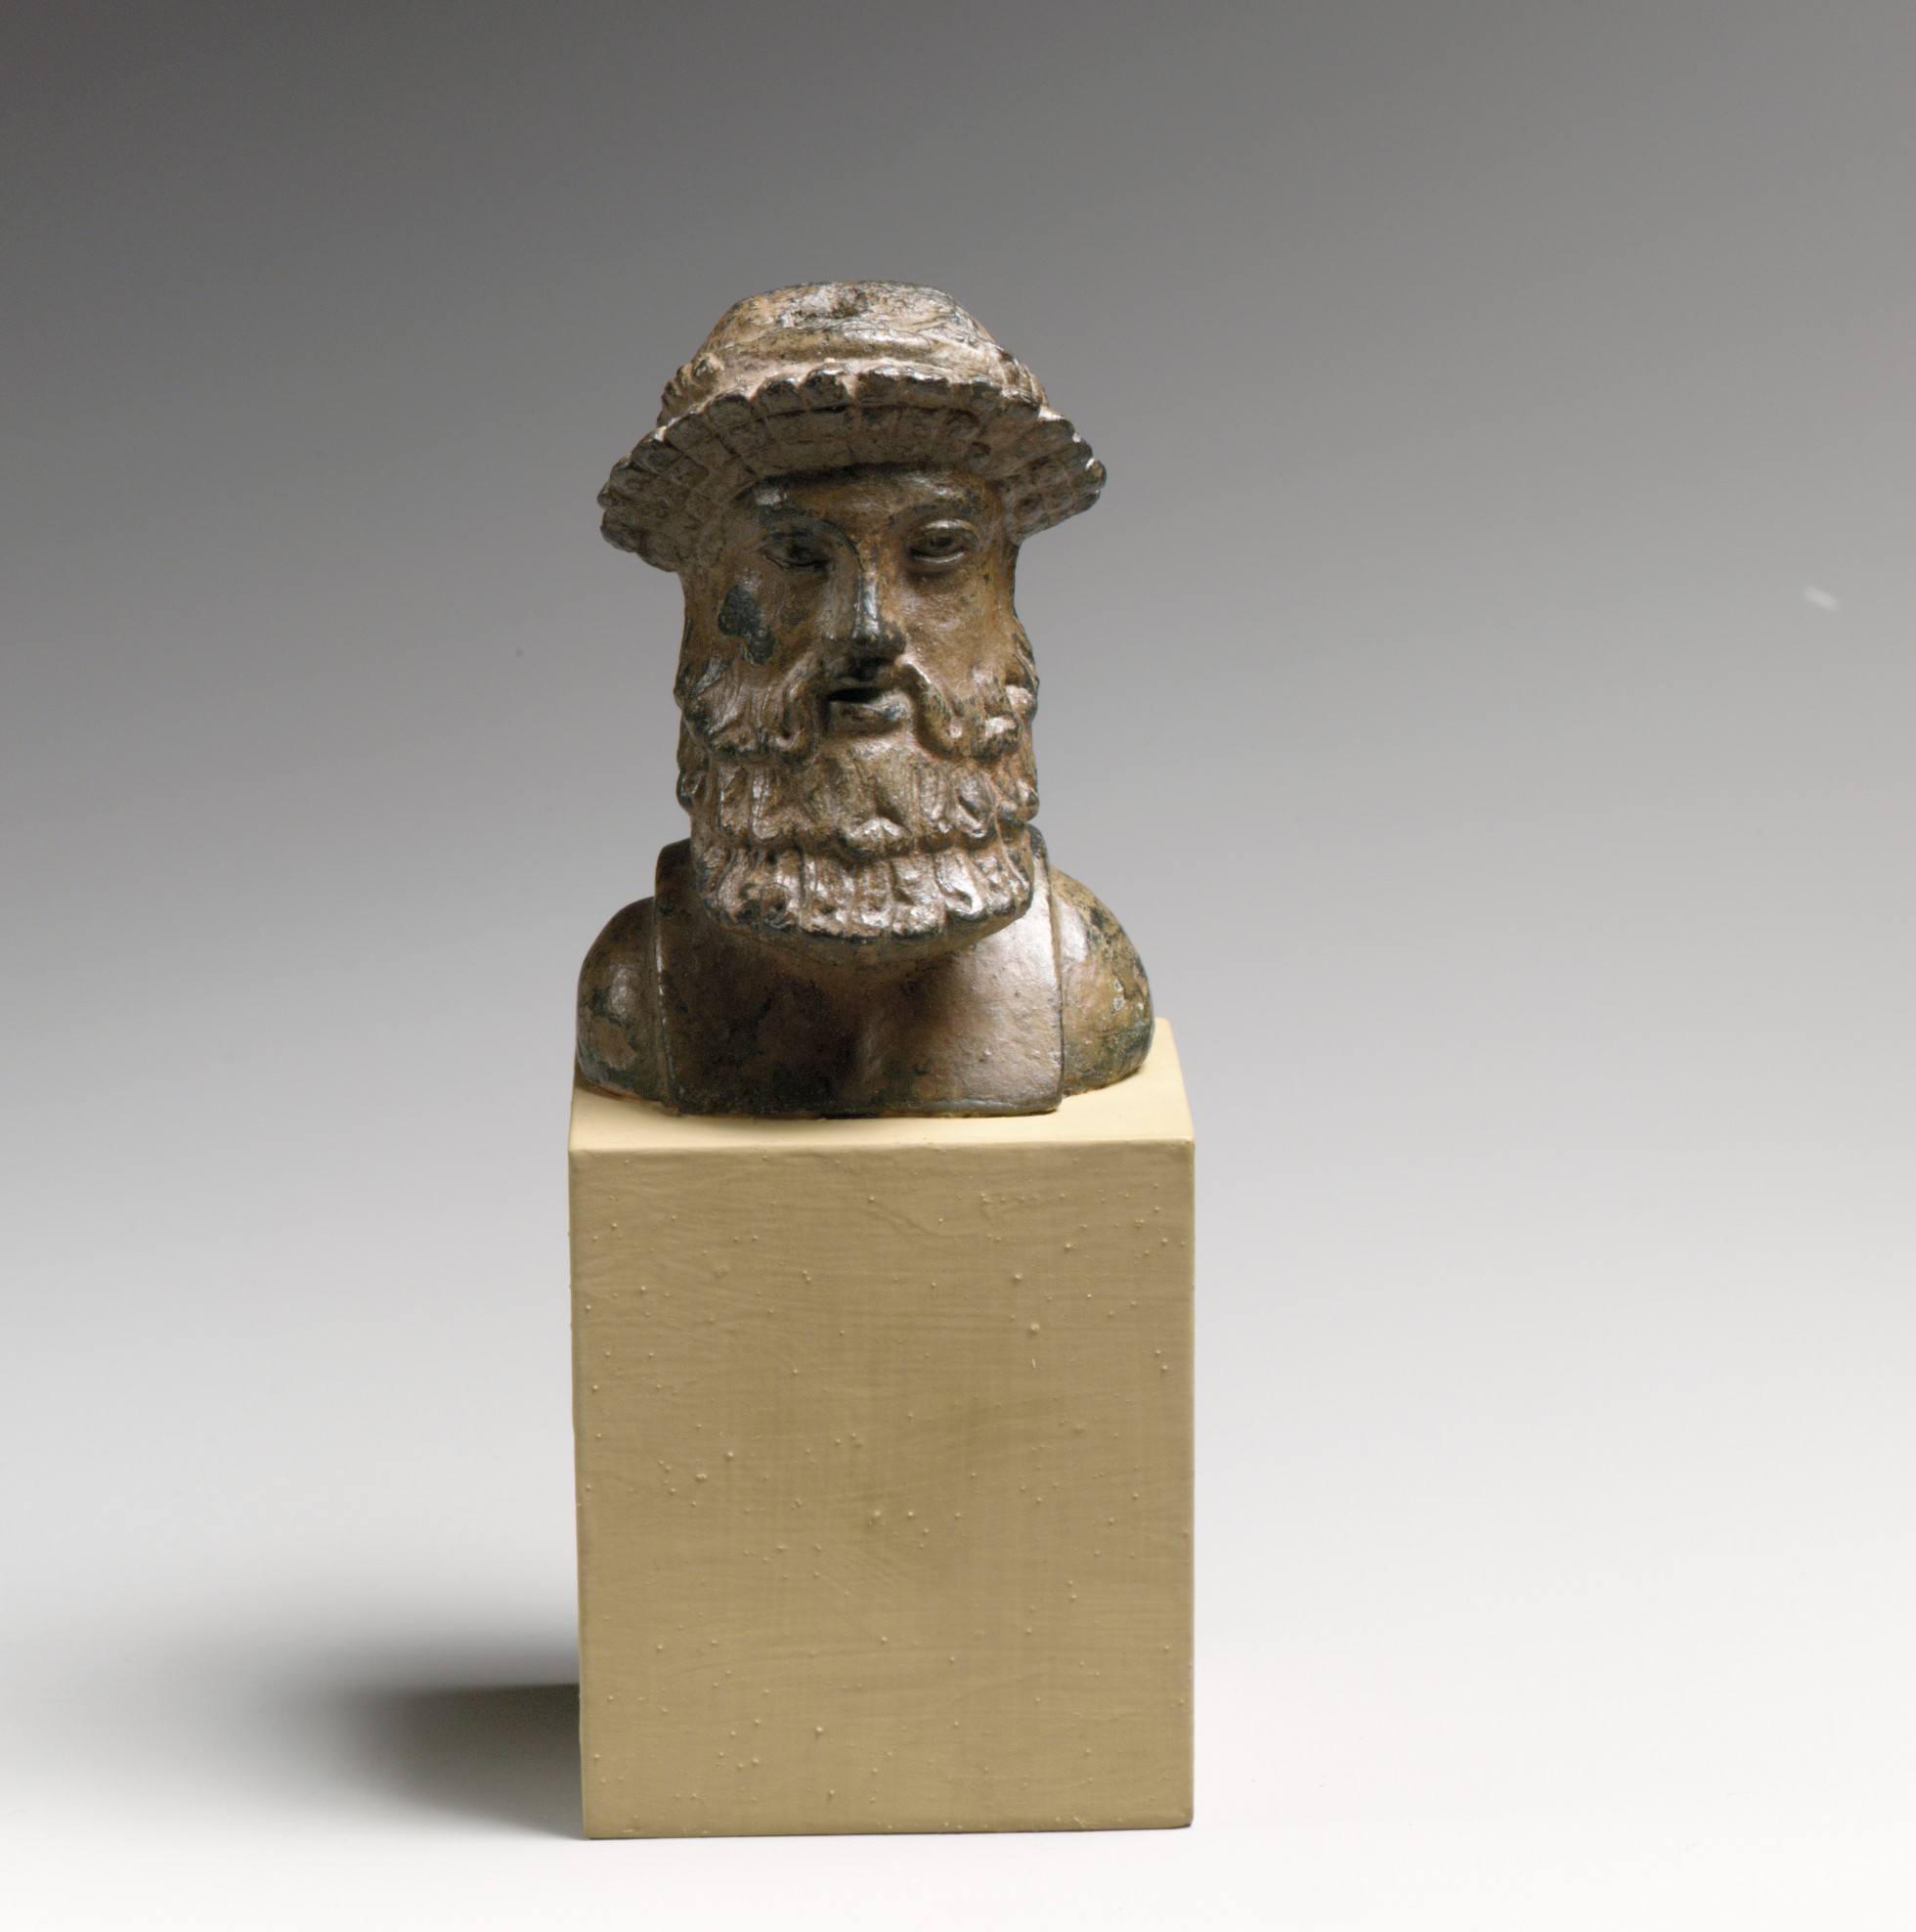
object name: herm of hermes propylaios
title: Bronze herm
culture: roman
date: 1-200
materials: bronze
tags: heads,hermes